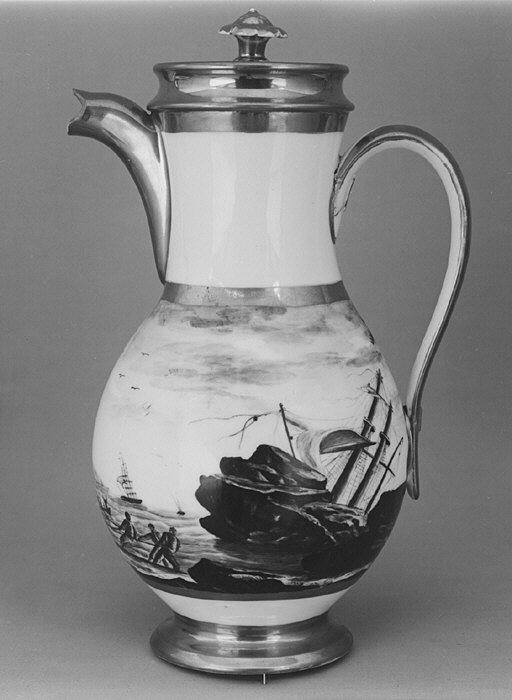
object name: coffeepot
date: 1805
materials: hard paste porcelain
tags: human figures,ships